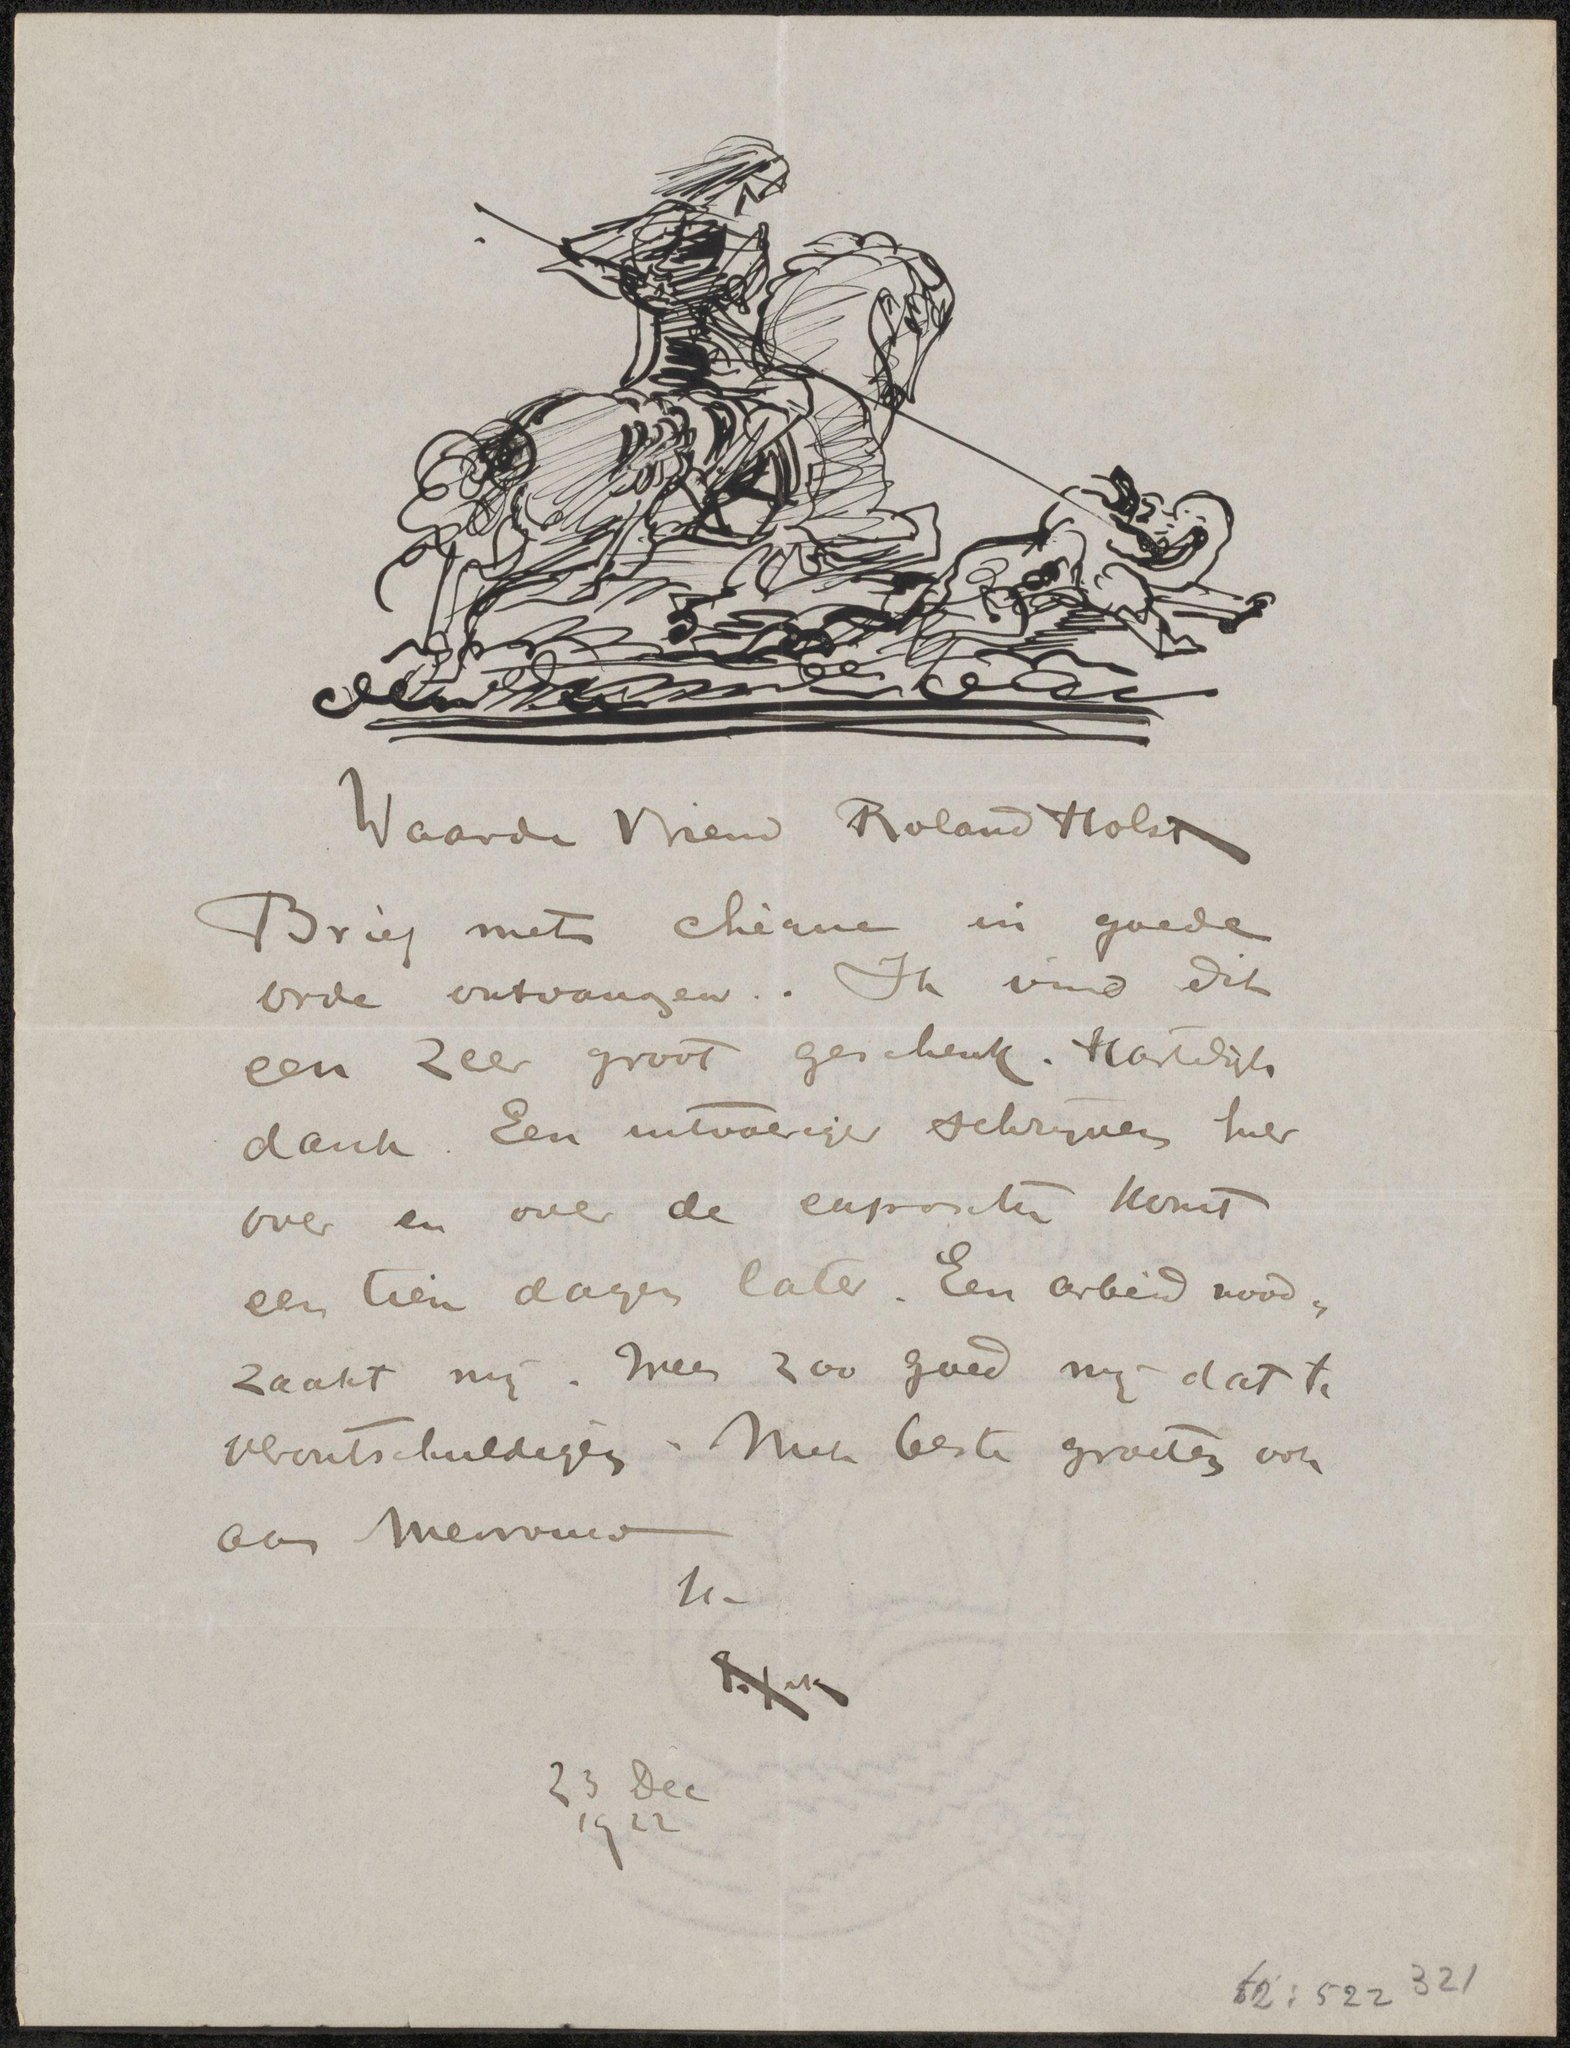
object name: letter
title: Brief aan Richard Roland Holst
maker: willem van konijnenburg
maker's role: draughtsman, painter, print maker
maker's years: 1868-1943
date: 1922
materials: ink, paper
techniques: pen, writing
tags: richard nicolaüs roland holst, st. george and the dragon: dressed in armour and mounted on a (white) horse he brandishes his sword (his lance lies already broken on the ground); the princess nearby may be shown praying or fleeing, exhibition ~ art, money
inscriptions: watermark